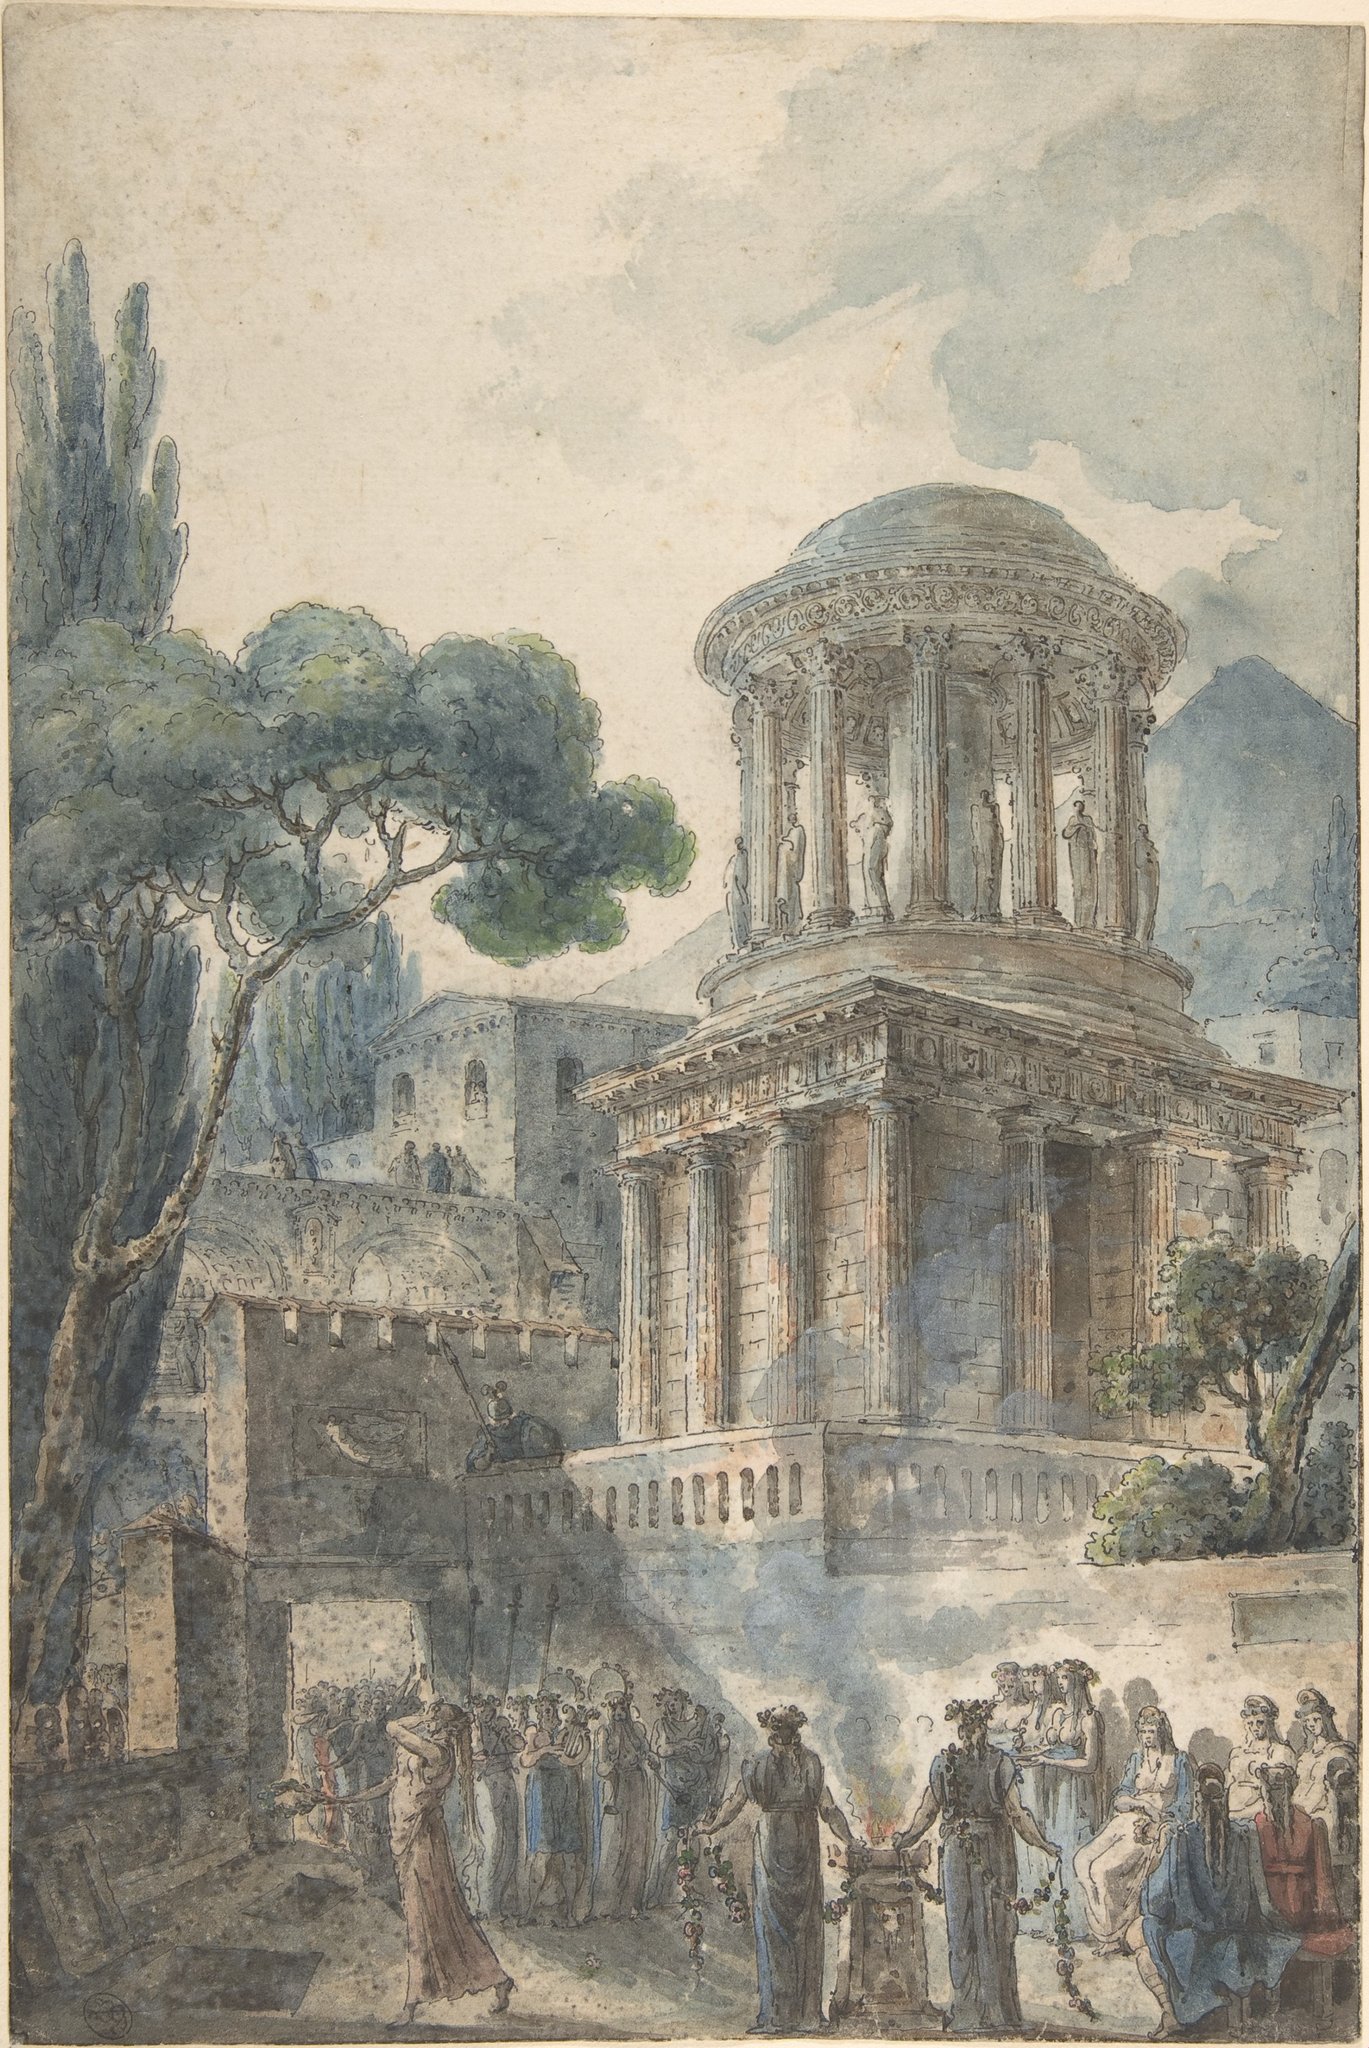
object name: drawing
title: Ancient Scene with a Funeral Ceremony for an Actor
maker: louis jean desprez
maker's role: artist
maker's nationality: french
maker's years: 1743-1804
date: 1777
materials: ink, watercolor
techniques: pen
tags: women,funerals